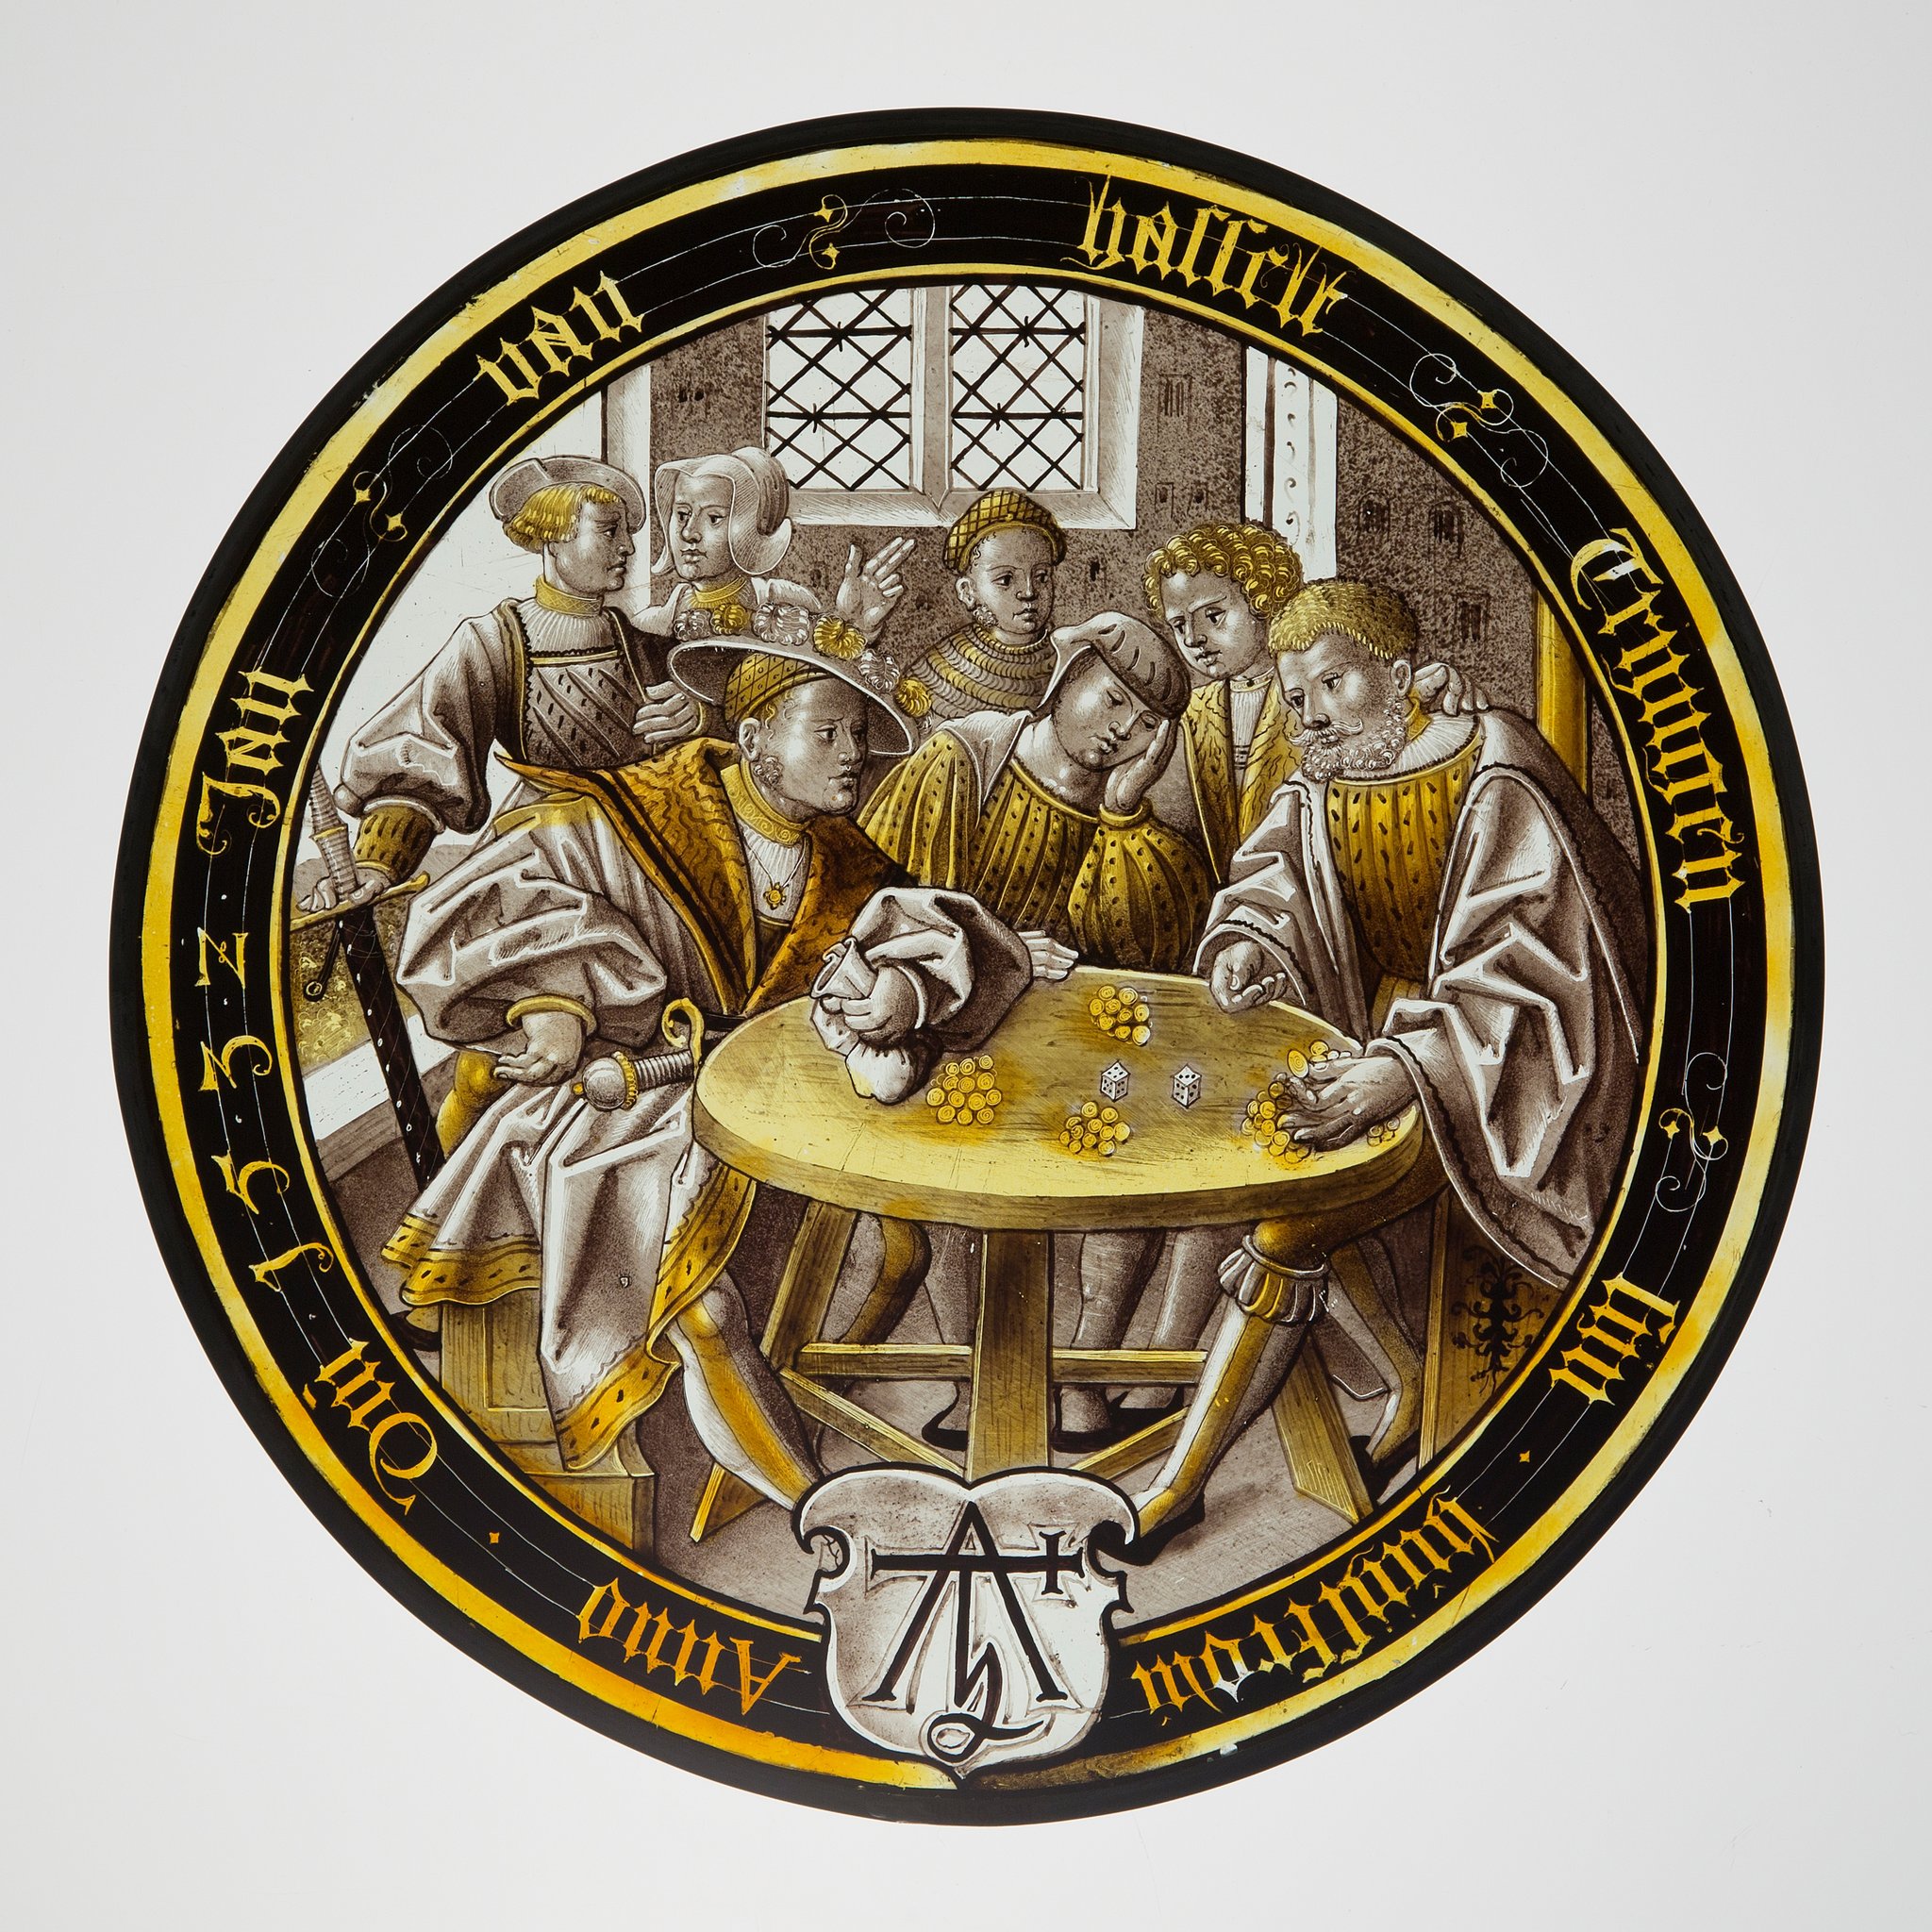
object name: roundel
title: The Prodigal Gambles (one of eight scenes from the story of the Prodigal Son)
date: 1532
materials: glass, paint, pigment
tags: men,women,games